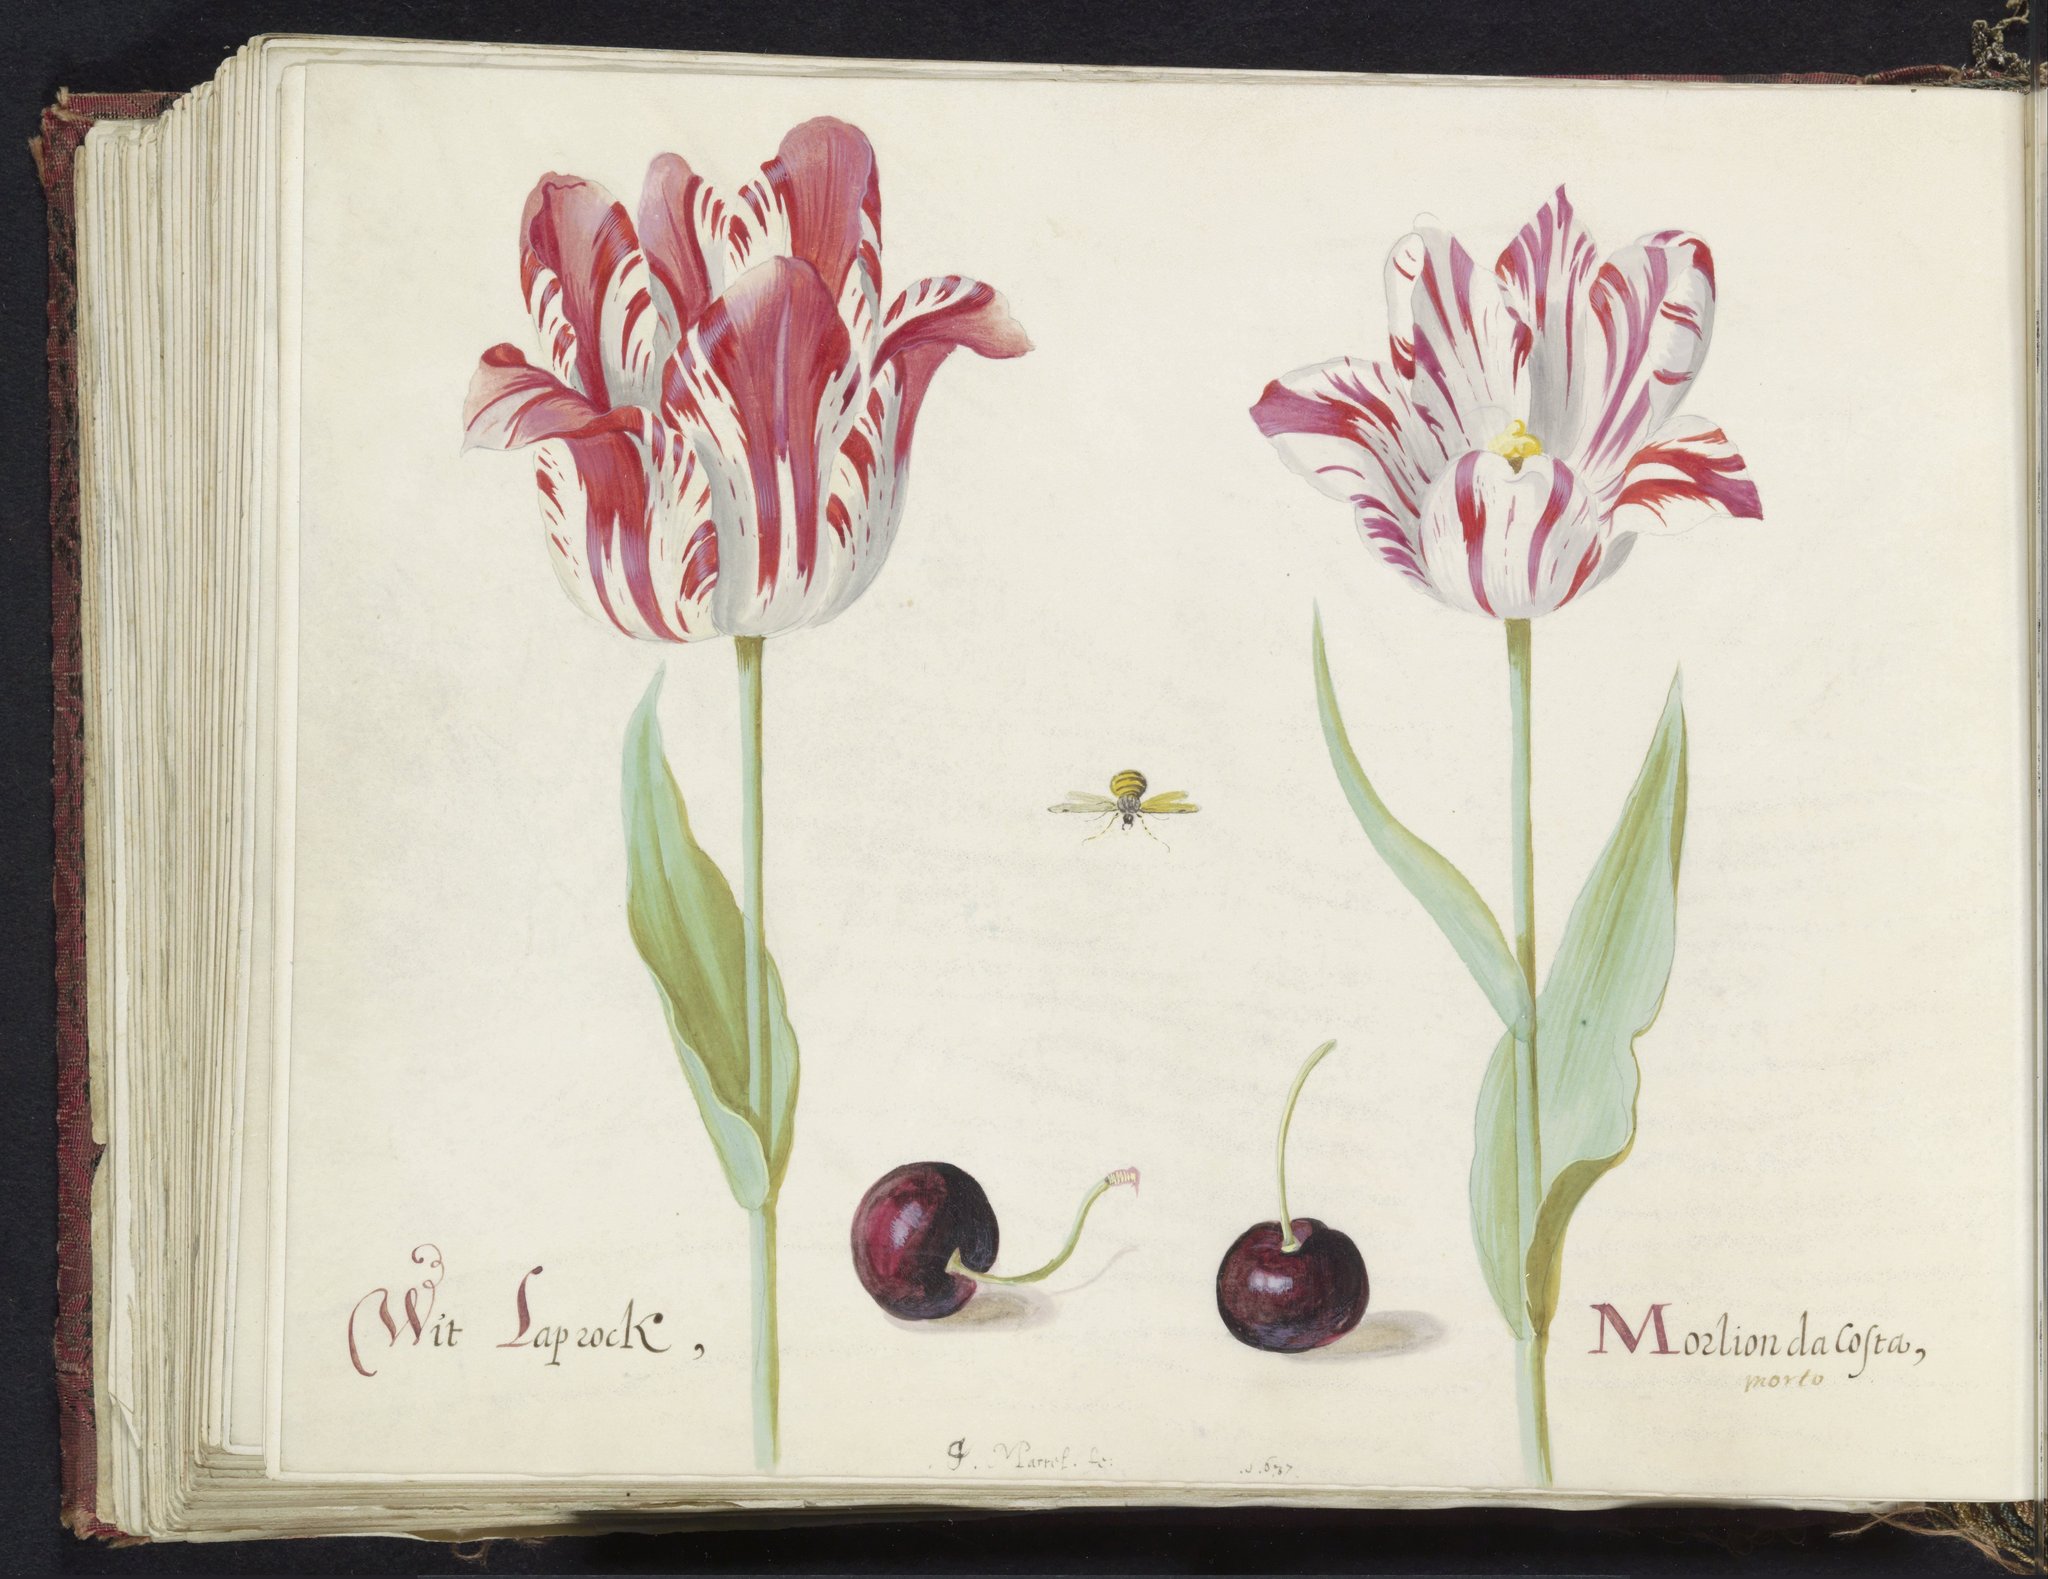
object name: drawing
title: Twee tulpen met twee kersen en bij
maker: jacob marrel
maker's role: draughtsman, painter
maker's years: 1614-1681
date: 1637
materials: paint, parchment, pencil, watercolor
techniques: brush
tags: insects: bee, fruits: cherry, flowers: tulip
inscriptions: date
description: De tekening maakt deel uit van een album.